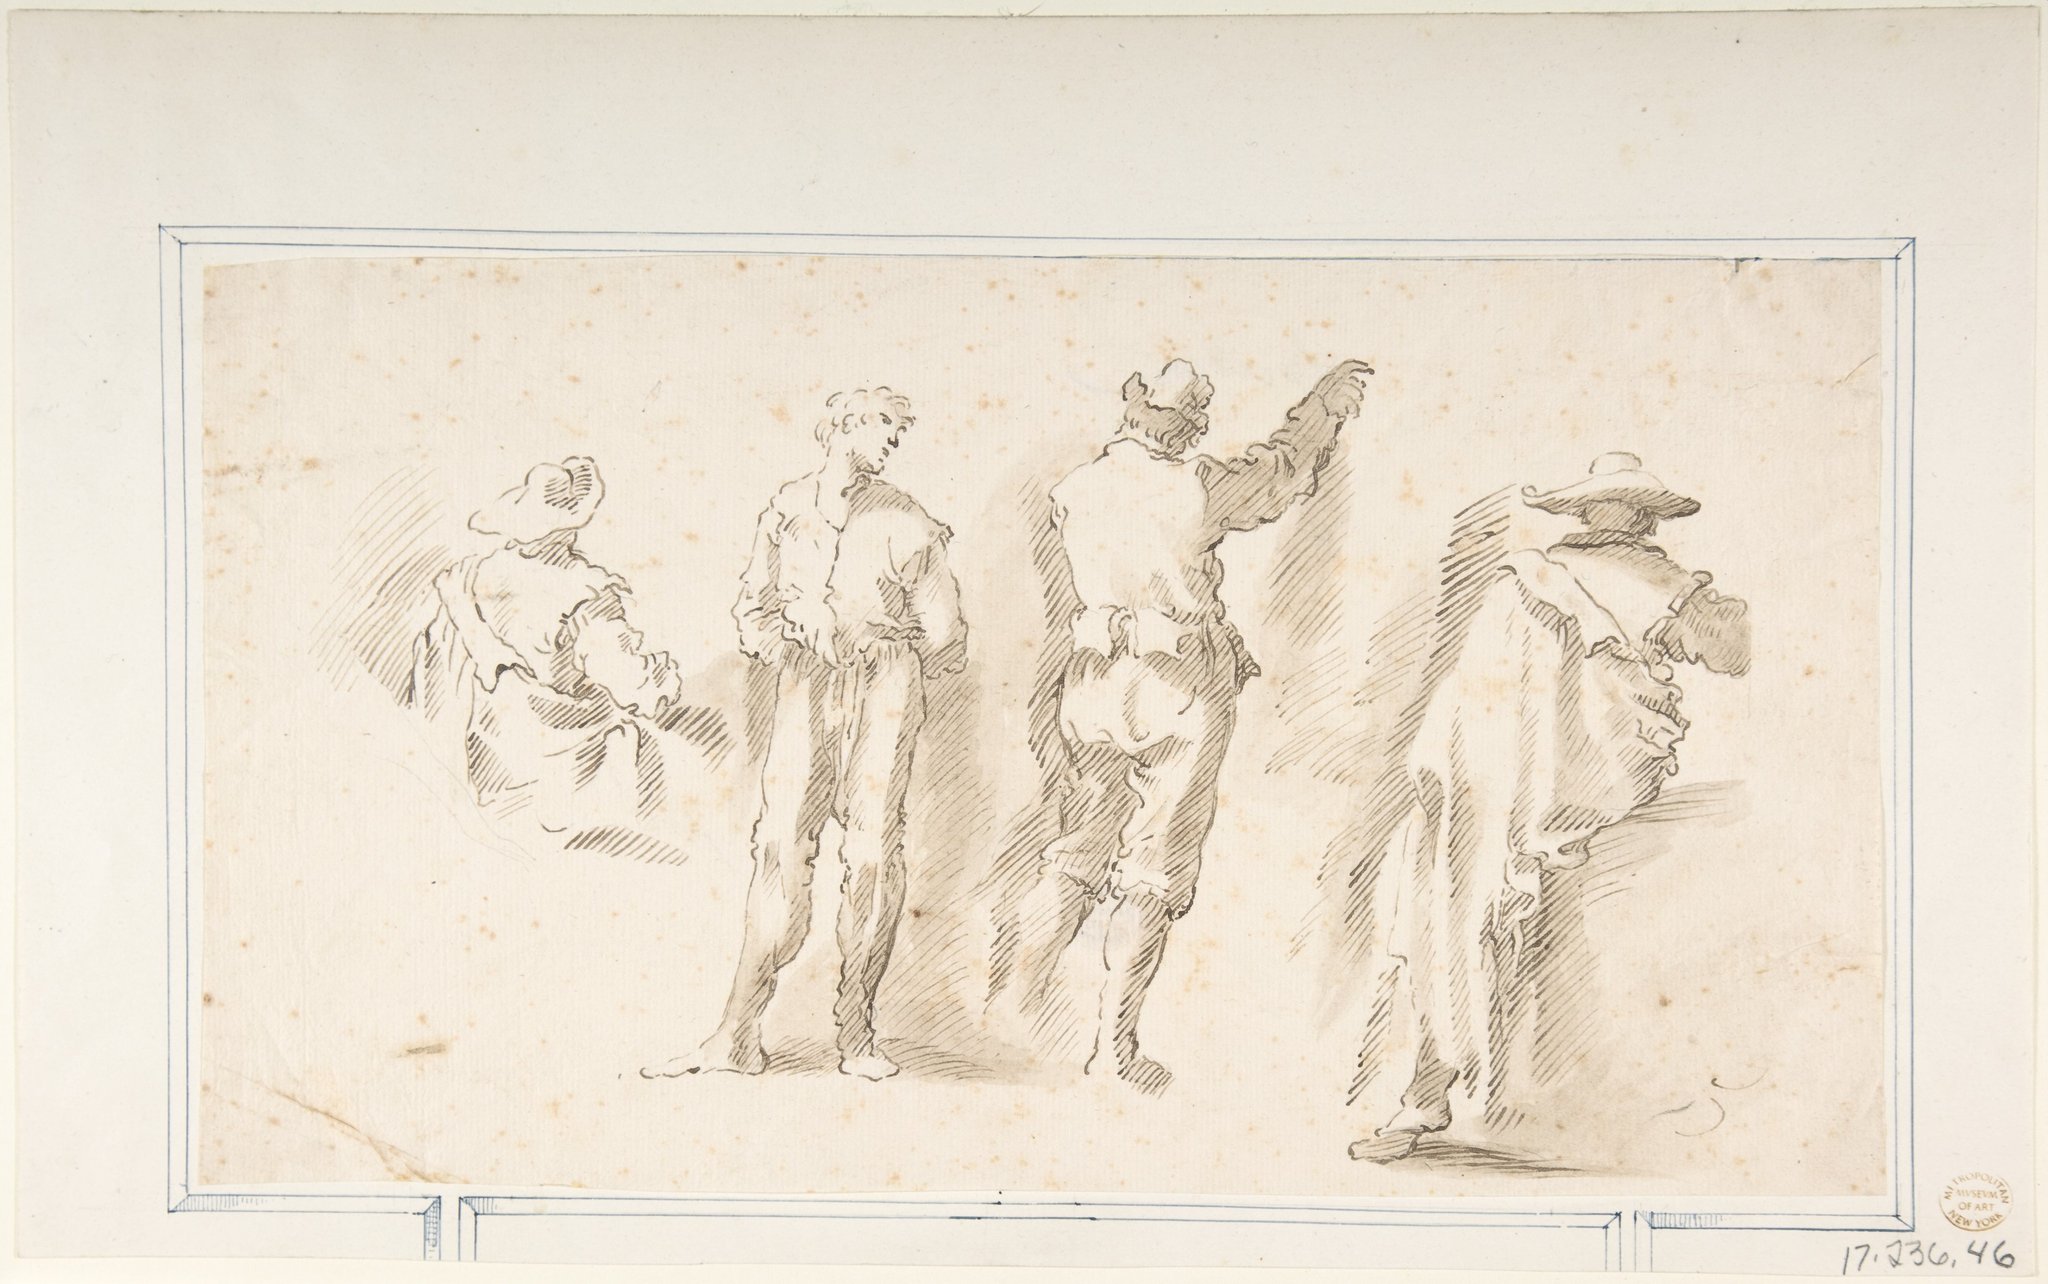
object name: drawing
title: Figure Studies: Two Standing and Two Seated Men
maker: micco spadaro (domenico gargiulo)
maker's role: artist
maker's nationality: italian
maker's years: 1609-1675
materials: ink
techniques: brush, pen, wash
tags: men